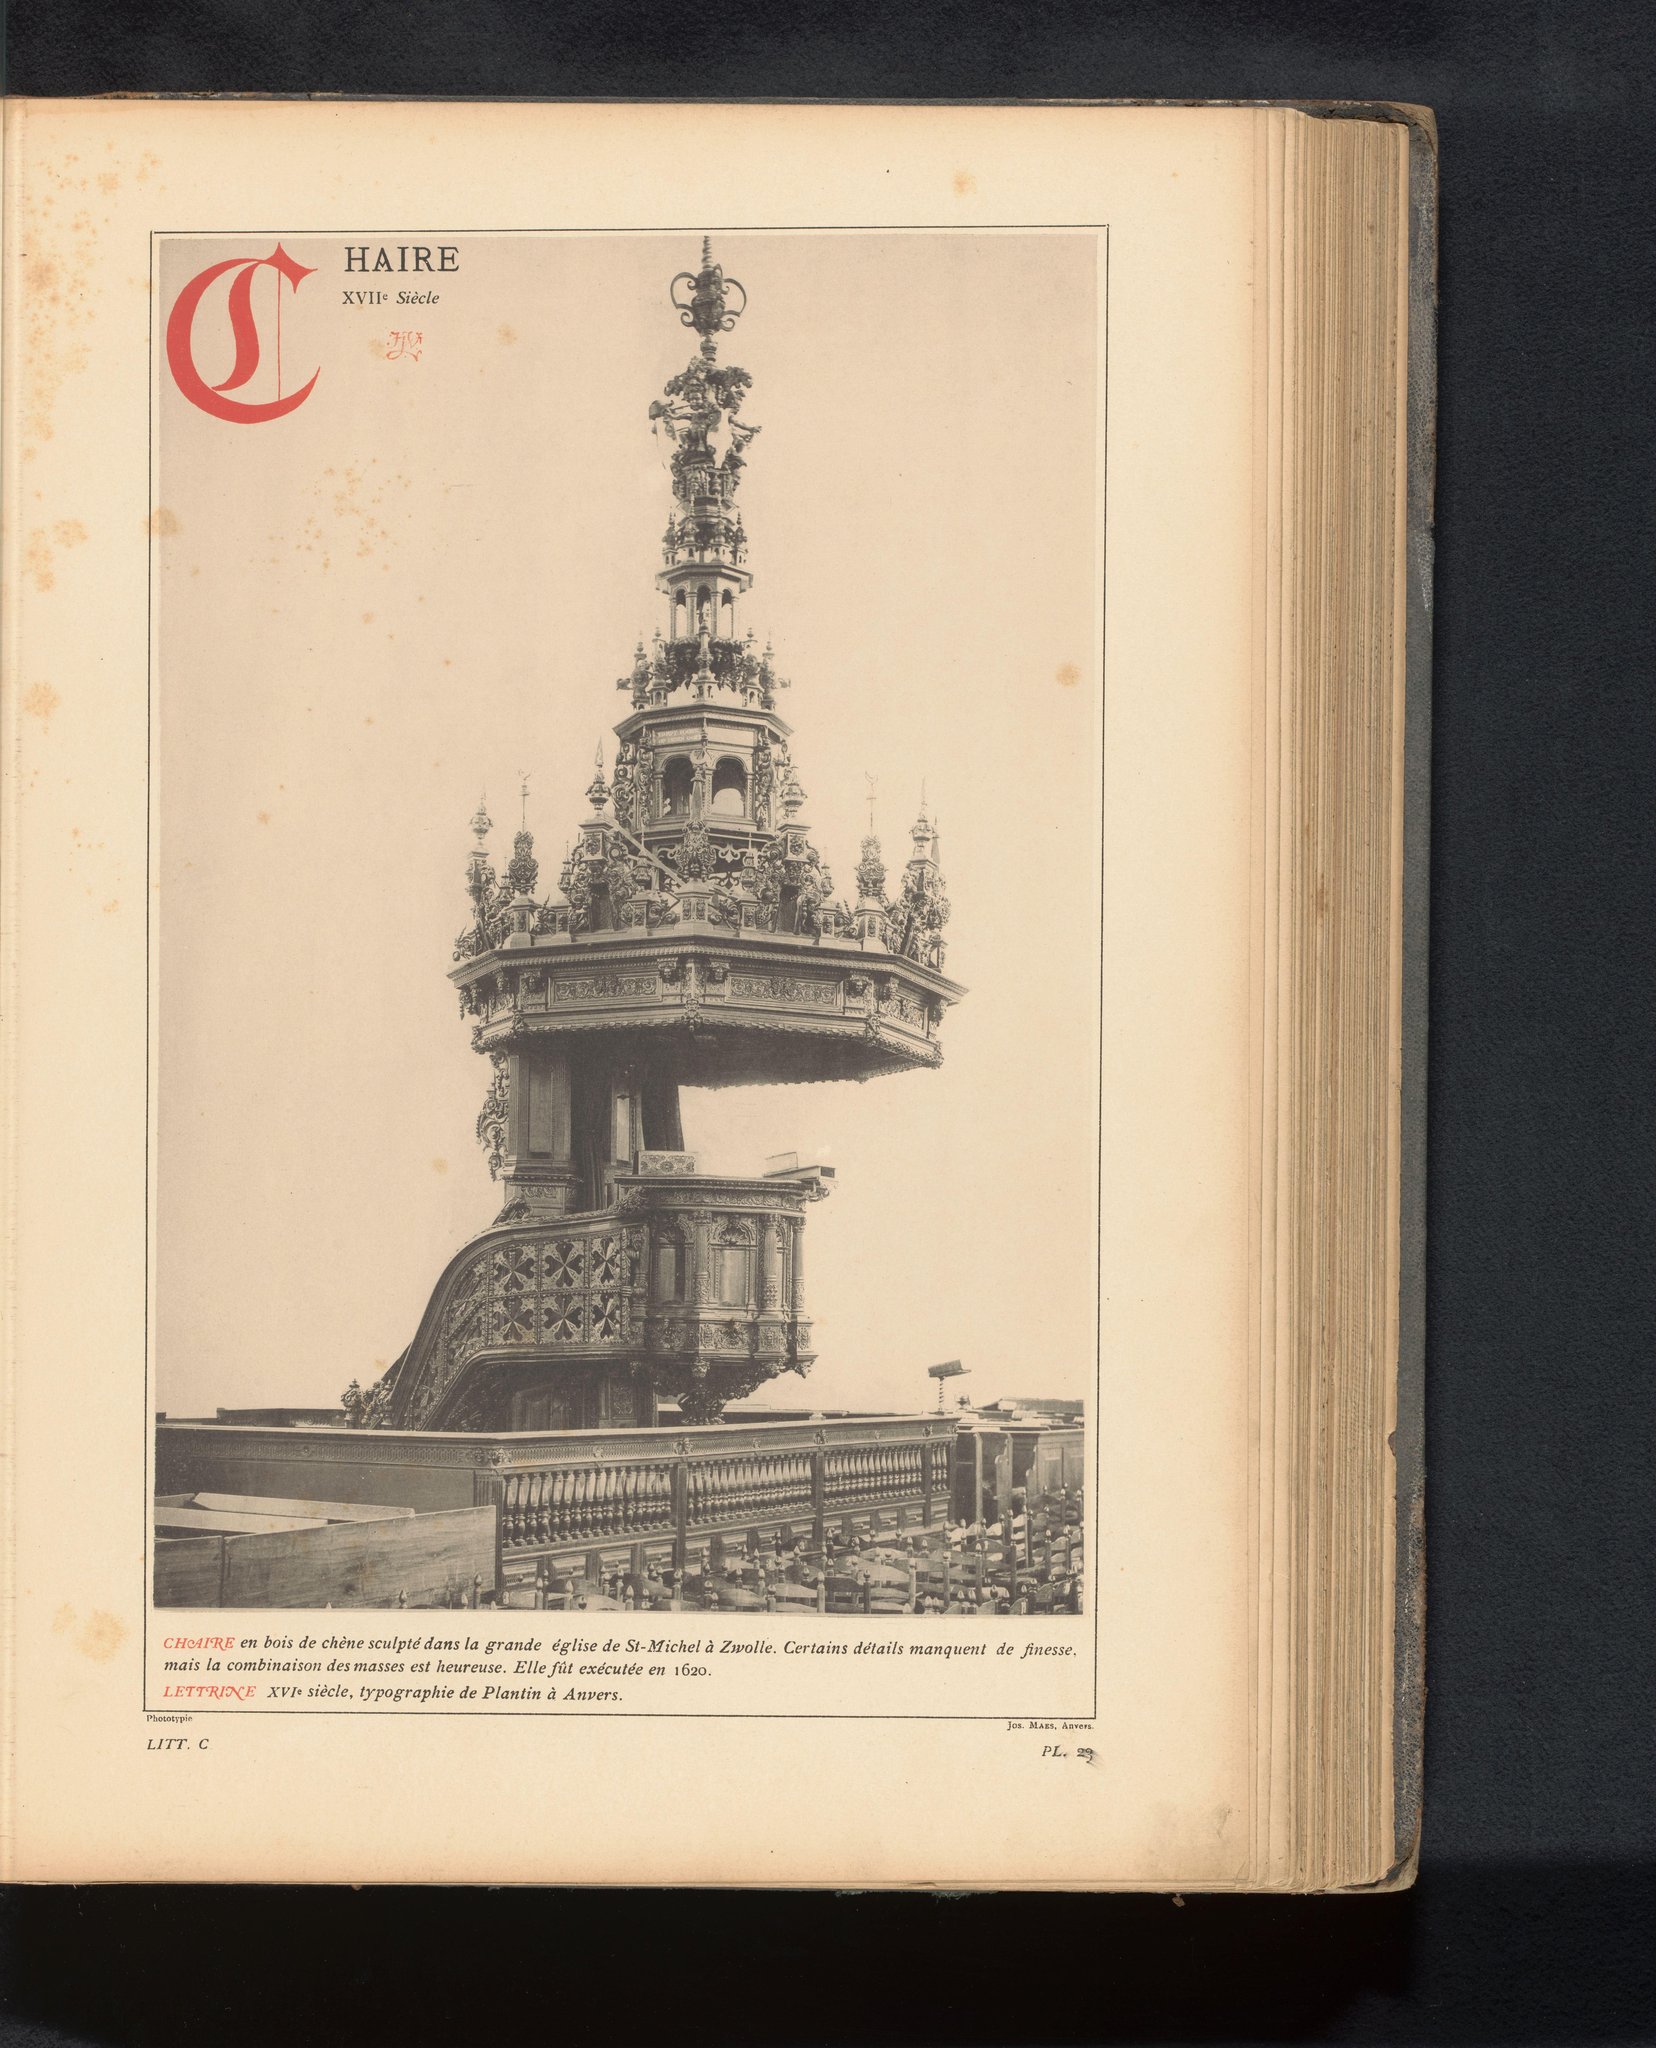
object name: photomechanical print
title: Preekstoel in de Sint-Michaëlskerk te Zwolle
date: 1875-1880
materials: paper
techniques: photograph, photolithography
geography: antwerp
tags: pulpit, ambo, chancel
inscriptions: inscription: ‘LITT. C. - PL. 23’, monogram: ‘JJvY’, inscription: ‘Chaire en bois (...)’